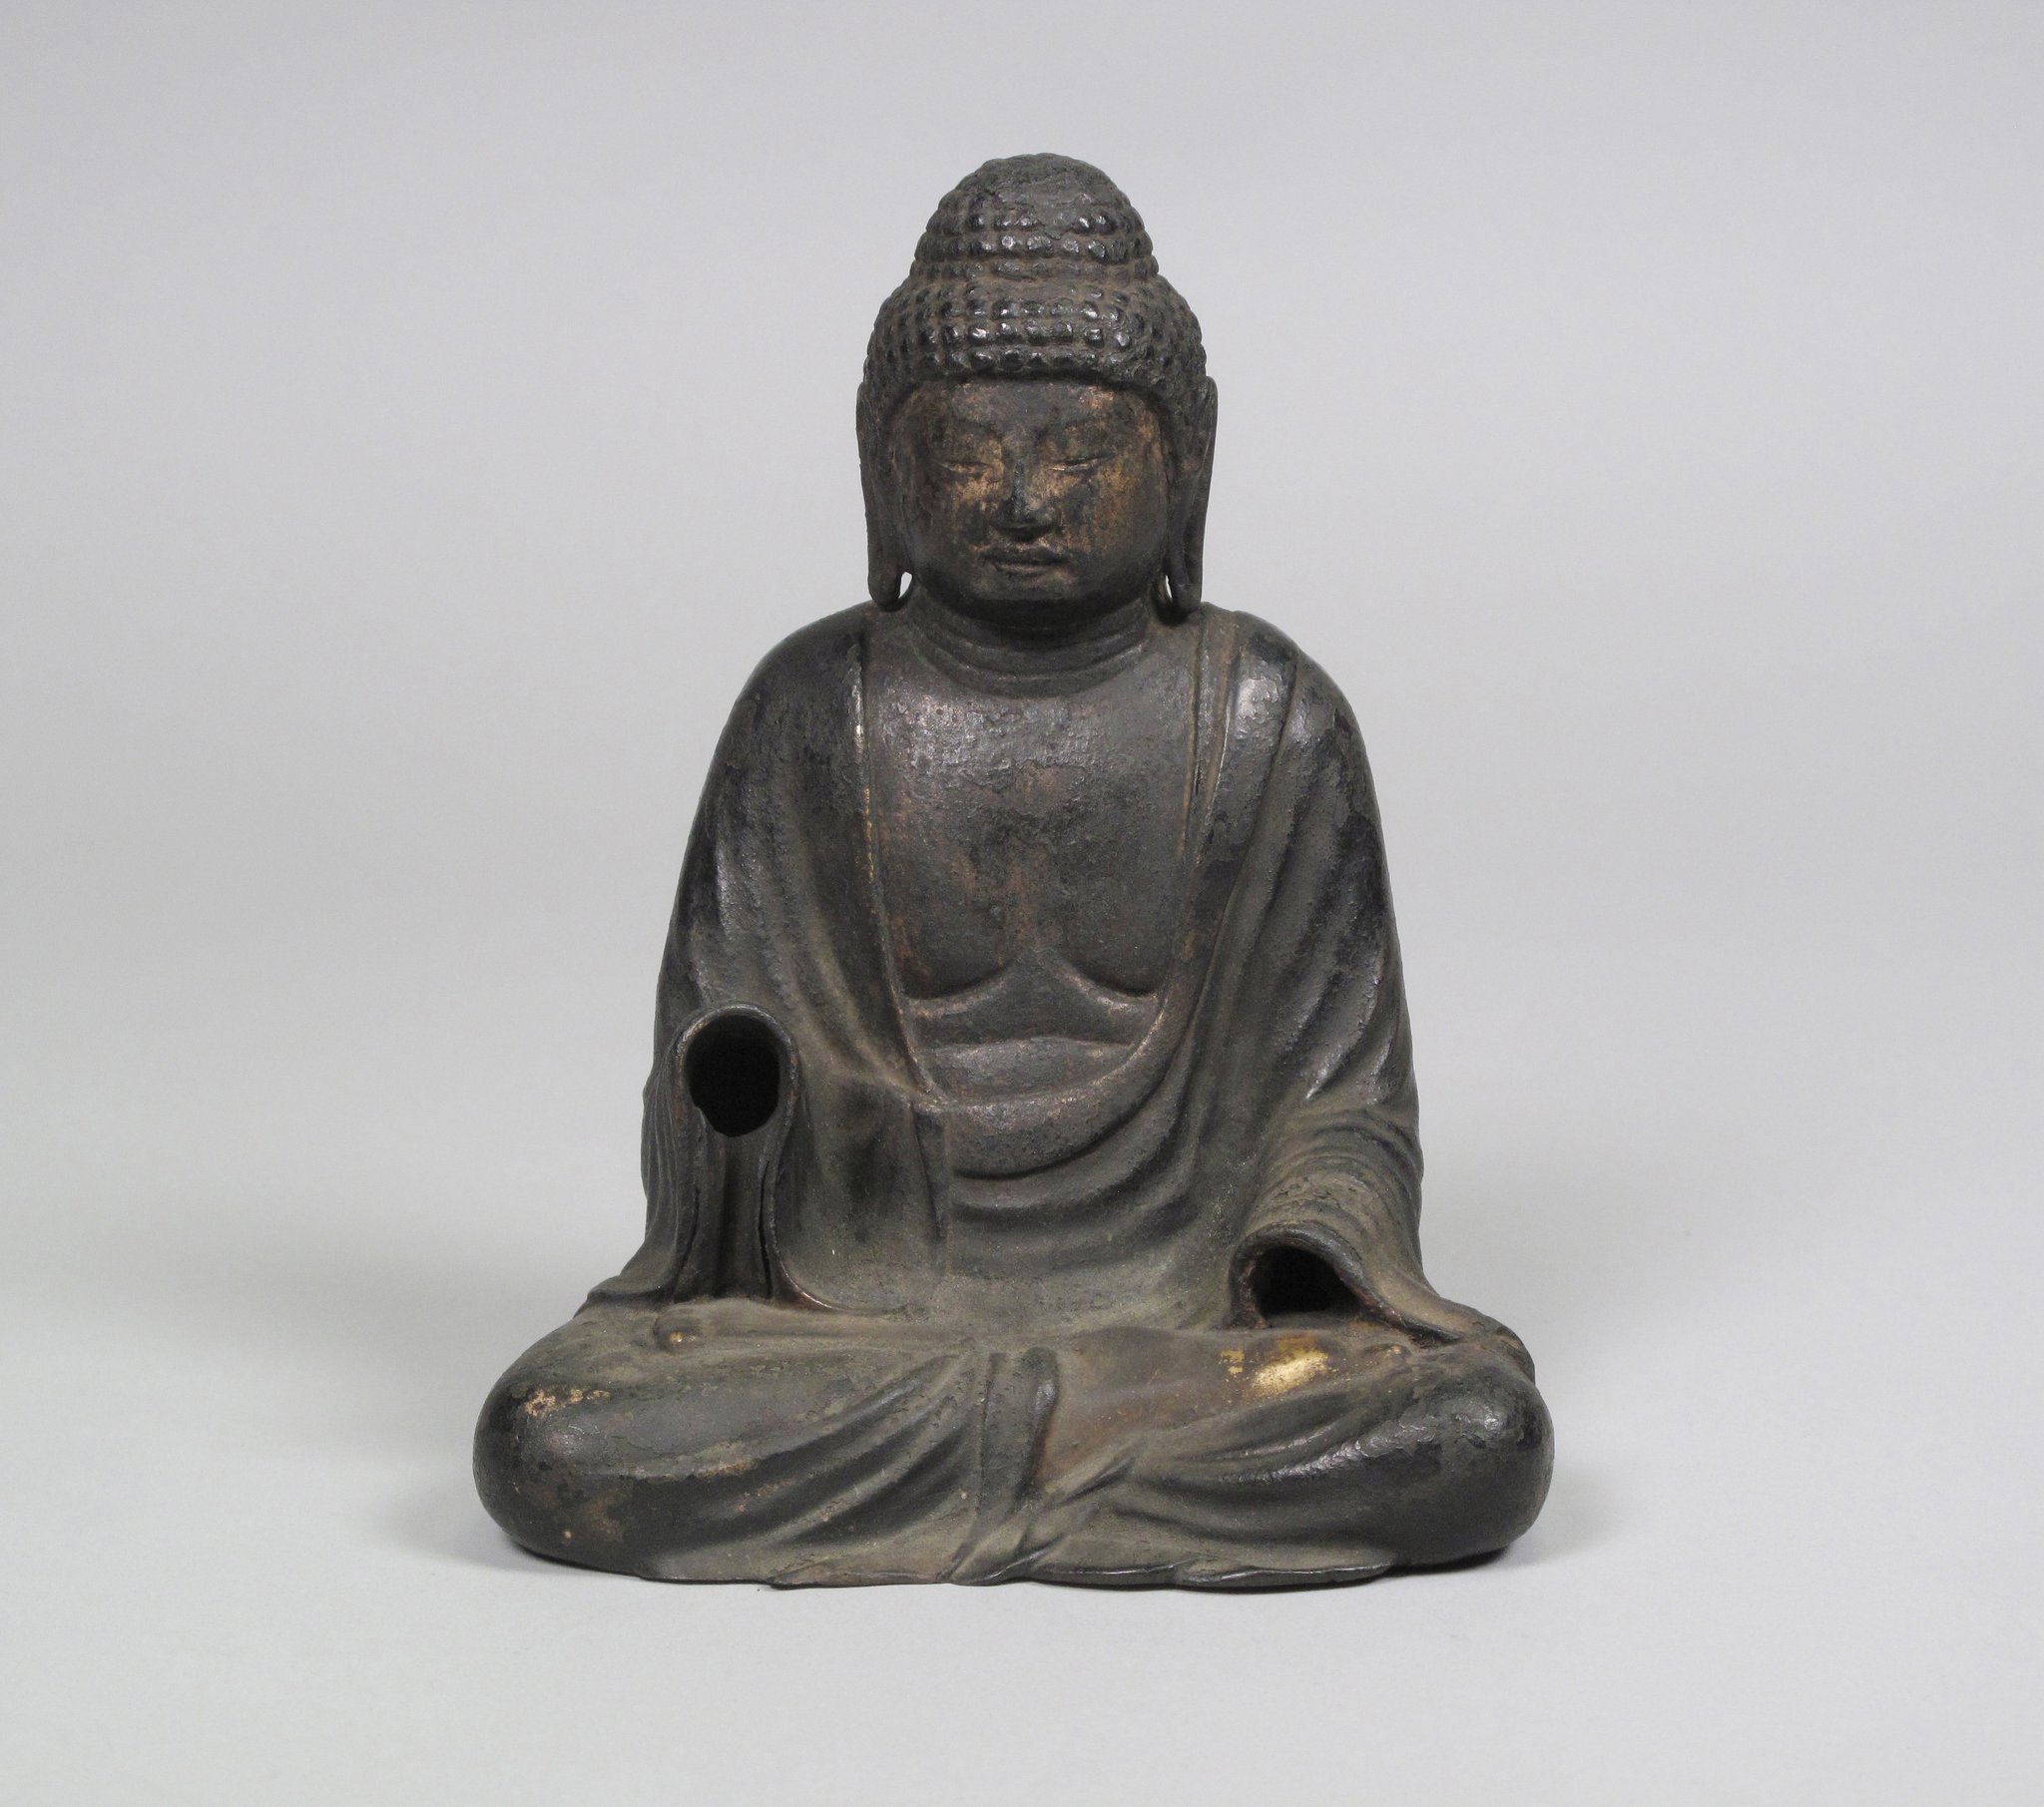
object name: figure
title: Seated Buddha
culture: japanese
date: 901-1100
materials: gilt bronze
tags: buddhism,buddha